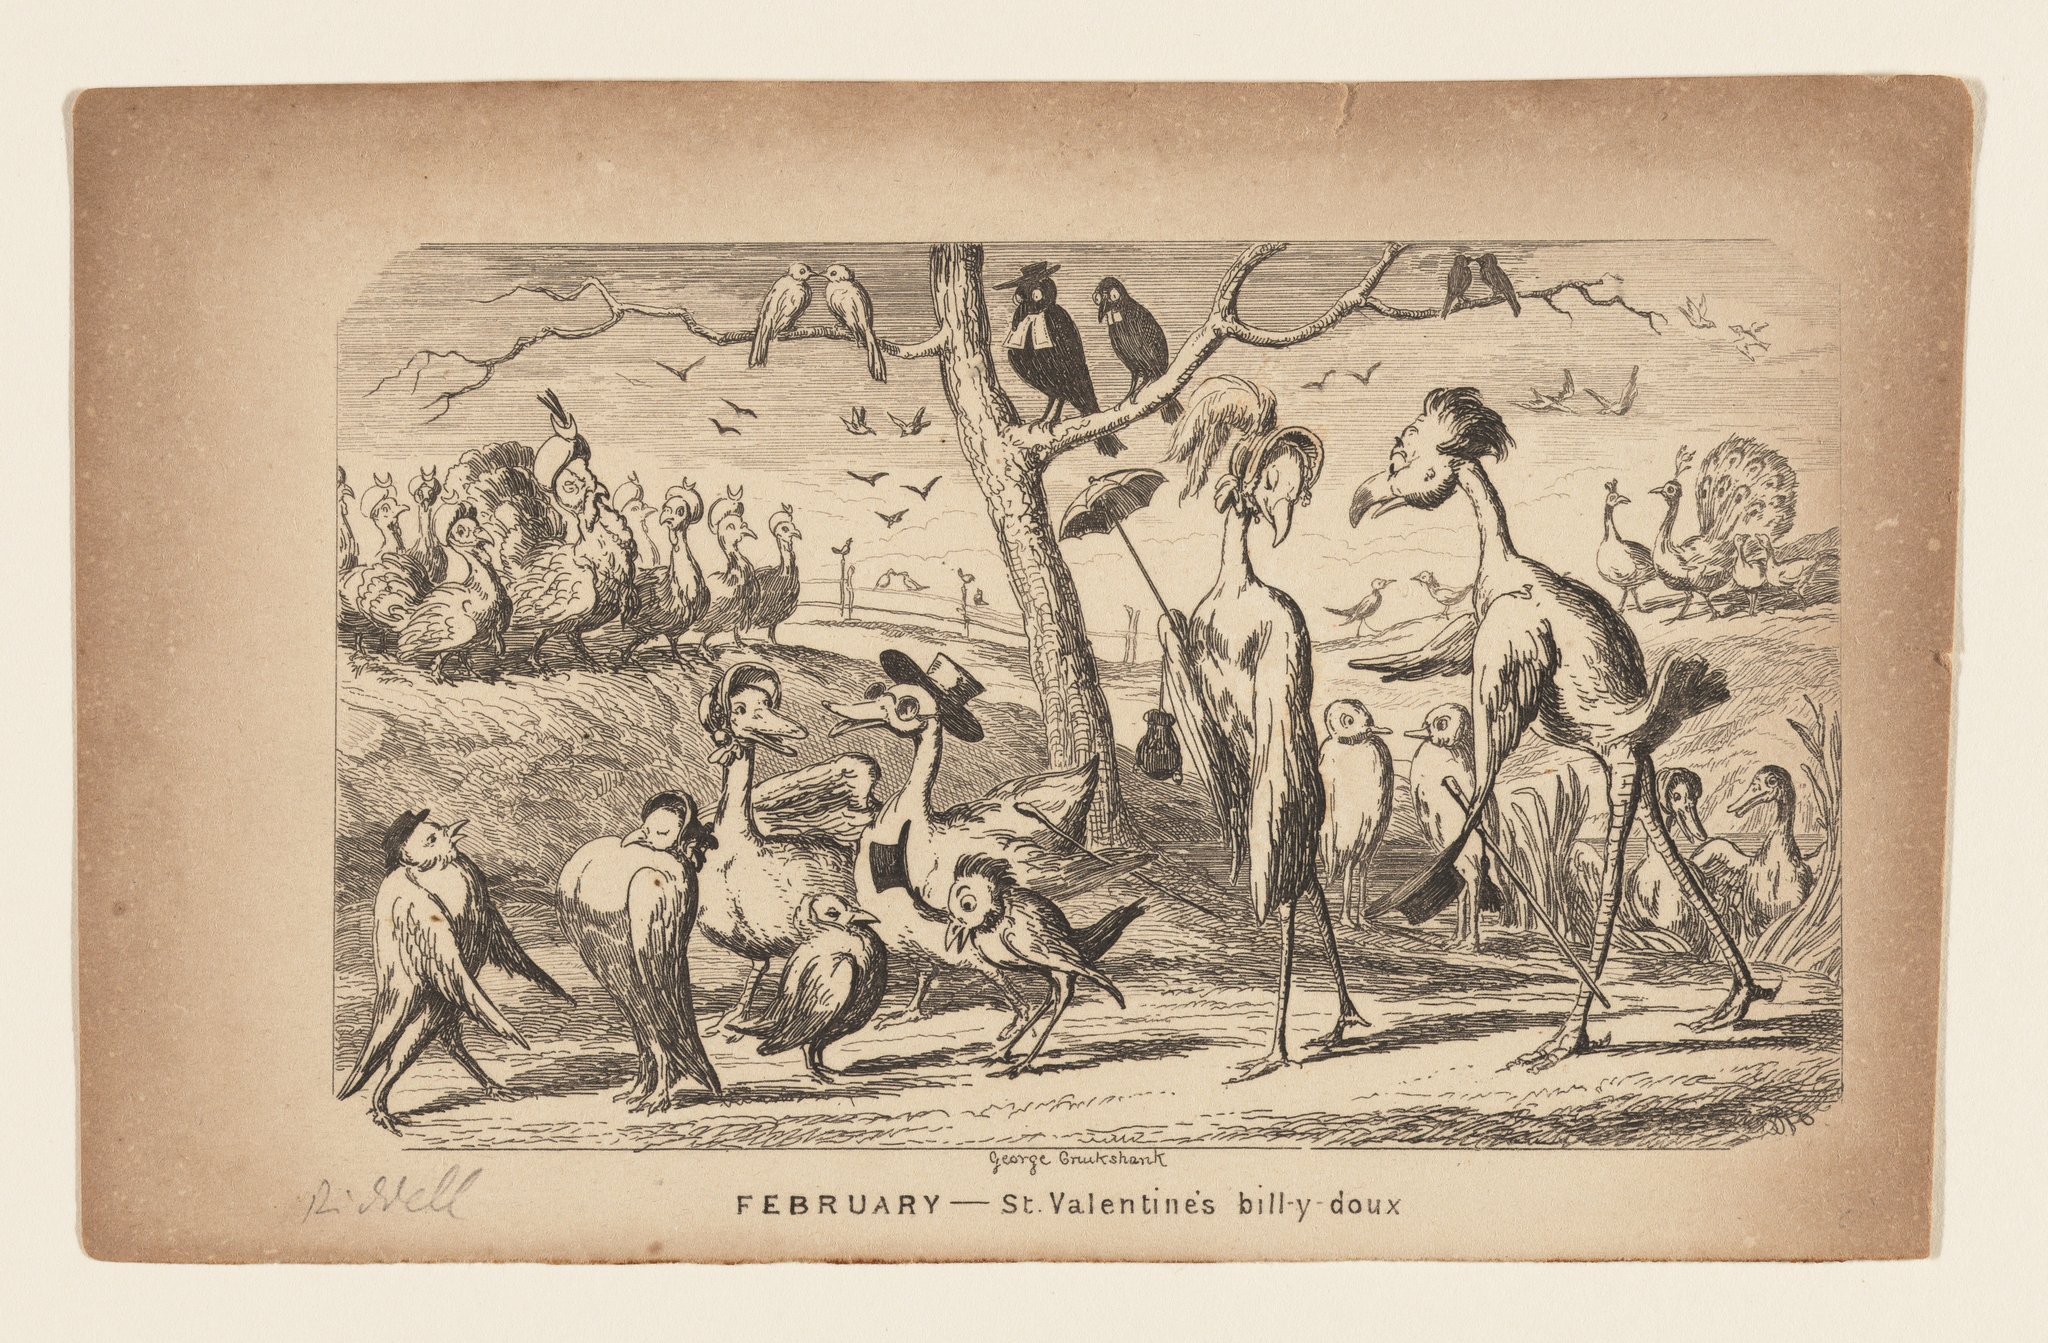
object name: valentine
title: Comic Valentine (St. Valentine bill-y doux)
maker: george cruikshank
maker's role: artist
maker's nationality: british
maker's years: 1792-1878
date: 1841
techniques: lithograph